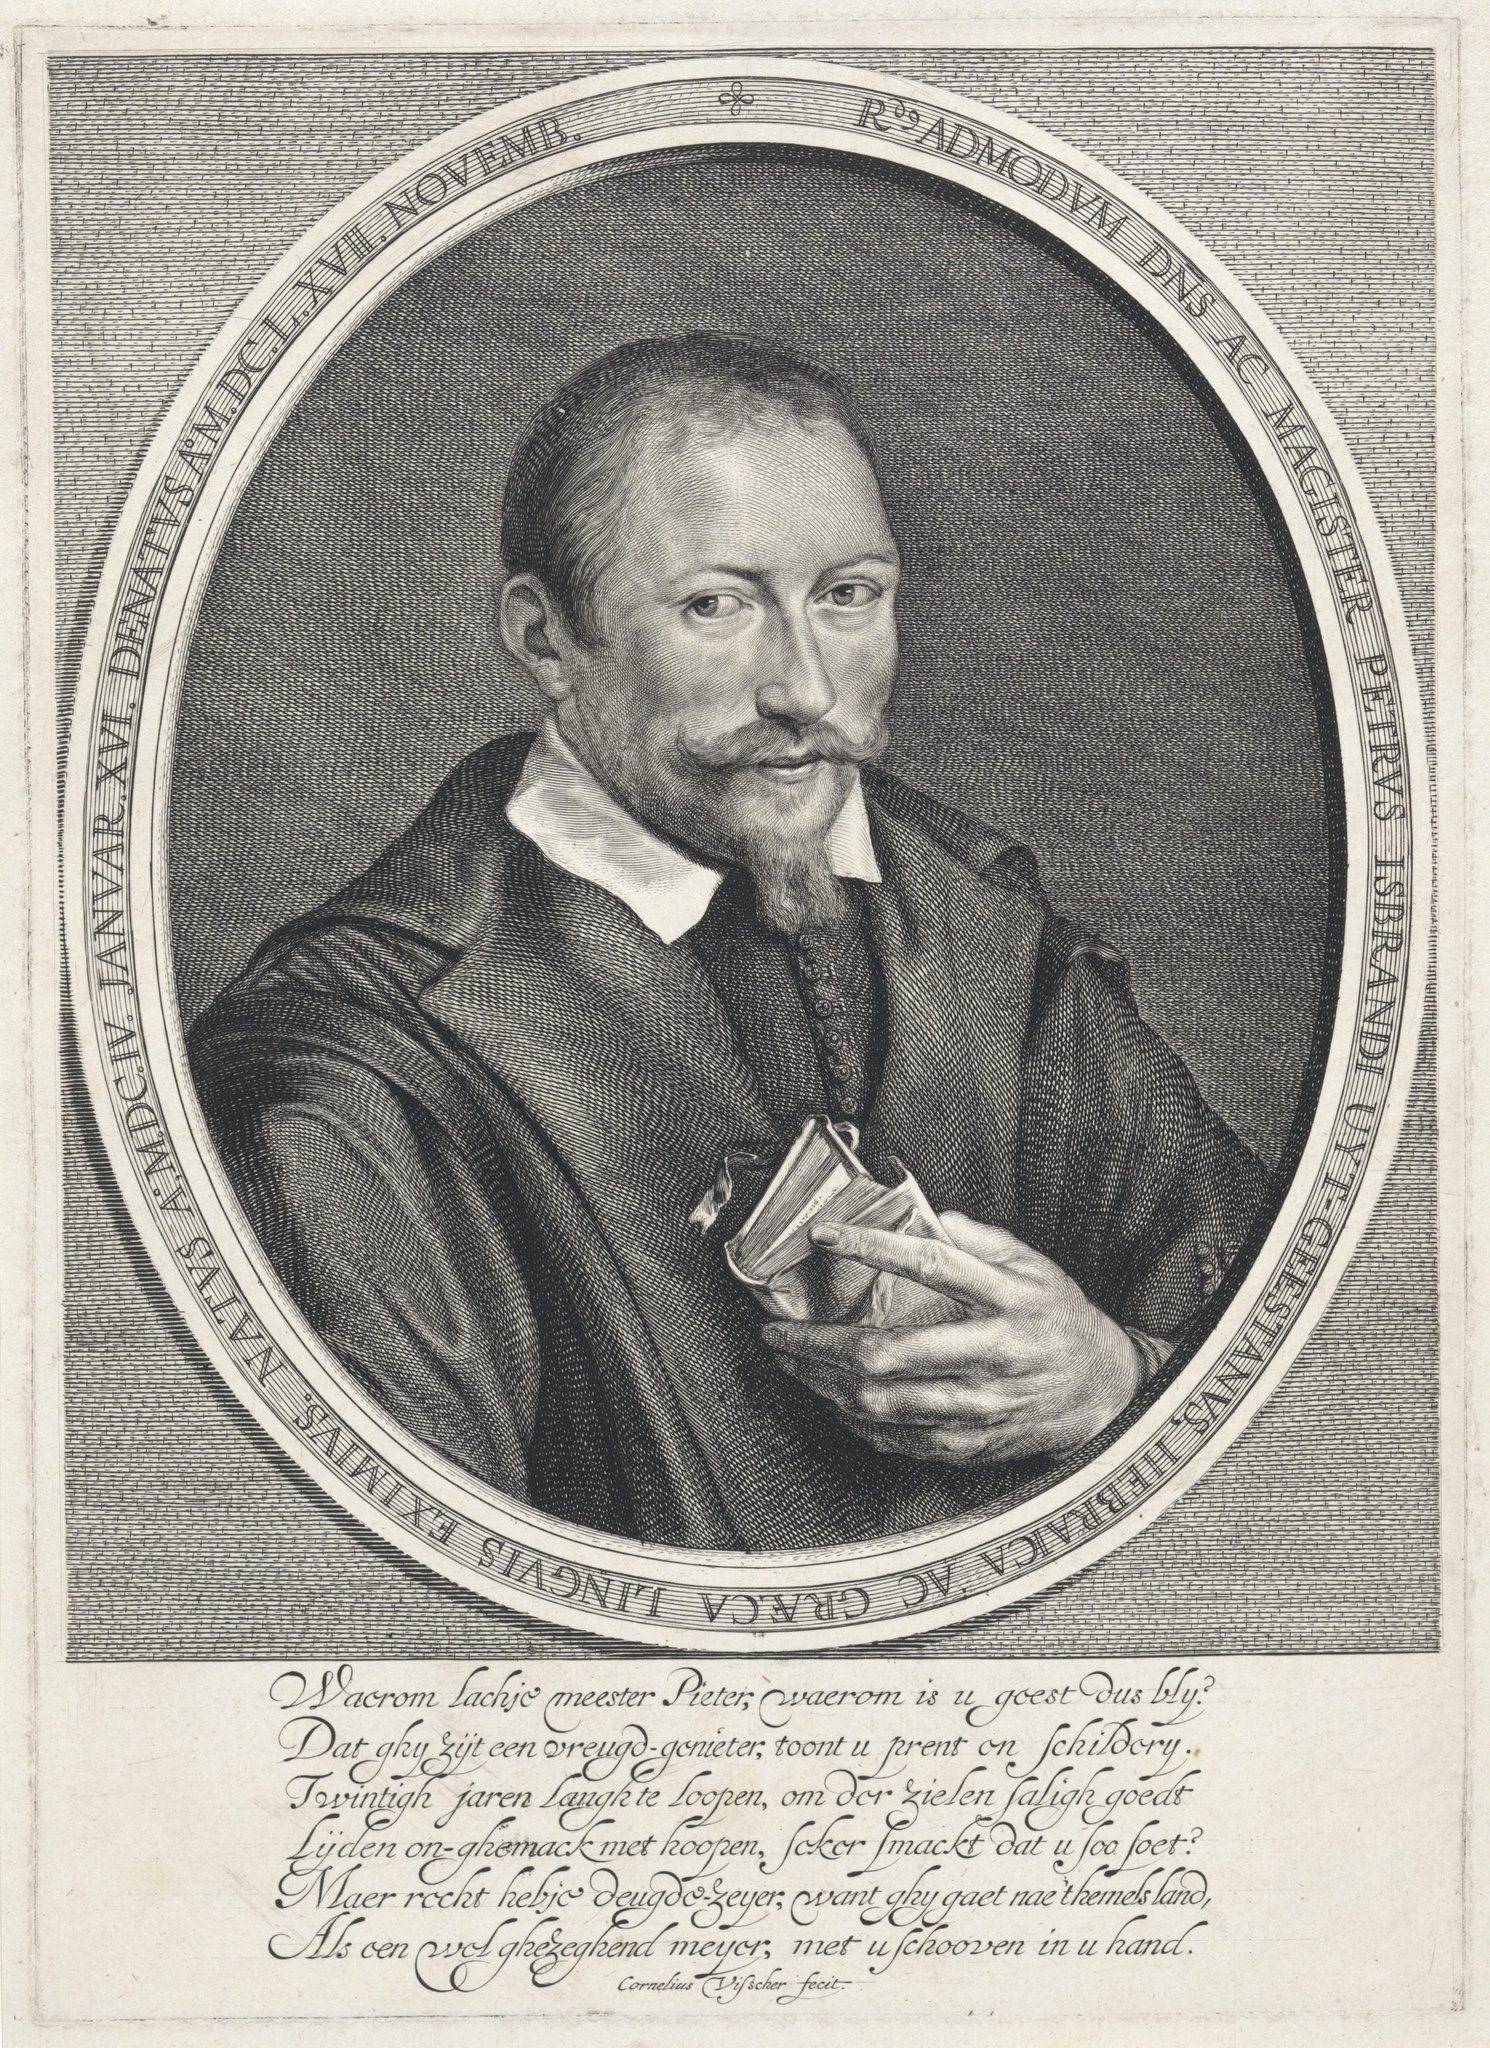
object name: print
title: Portret van Pieter Isbrandi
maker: nicolaas stenius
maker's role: schrijver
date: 1638-1658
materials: paper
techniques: engraving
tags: book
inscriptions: collector's mark: Lugt 240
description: Pieter Isbrandi met in zijn hand een boek. In de marge een lofdicht.